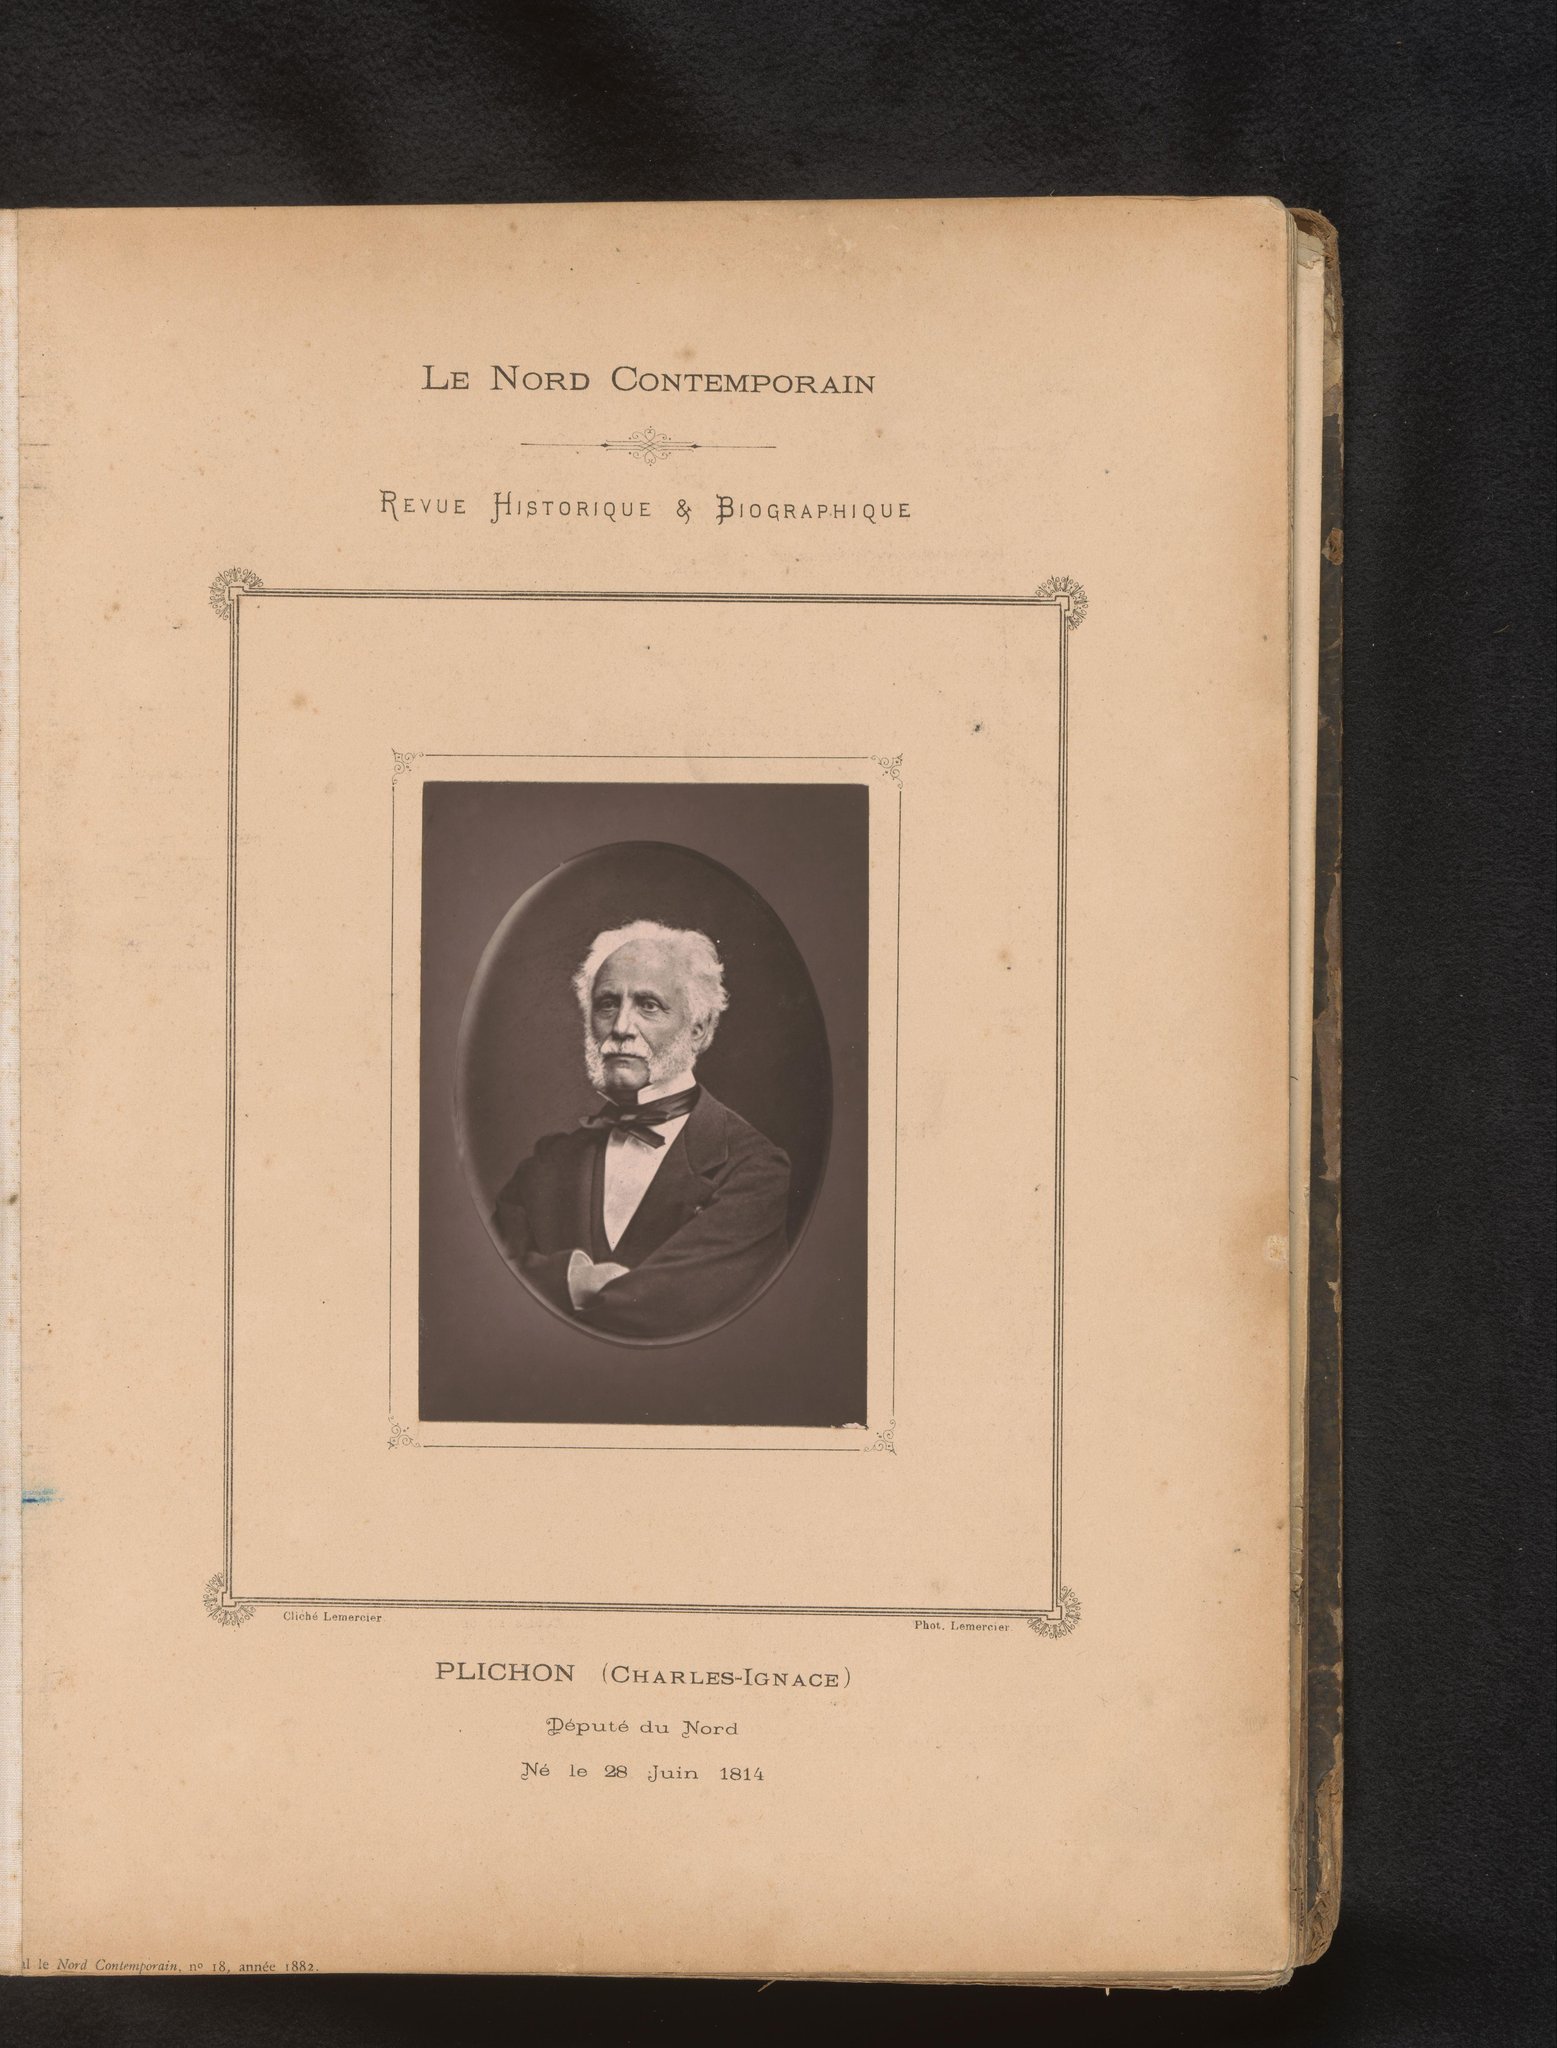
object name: page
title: Portret van Charles-Ignace Plichon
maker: lemercier (fotograaf)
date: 1877-1882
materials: paper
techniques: woodburytype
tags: historical persons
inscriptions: inscription: ‘Le Nord Contemporain/ Revue Historique & Biographique’, inscription: ‘[Journa]l le Nord Contemporain, No 18, année 1882.’, inscription: ‘Député du Nord/ Né le 28 Juin 1814’